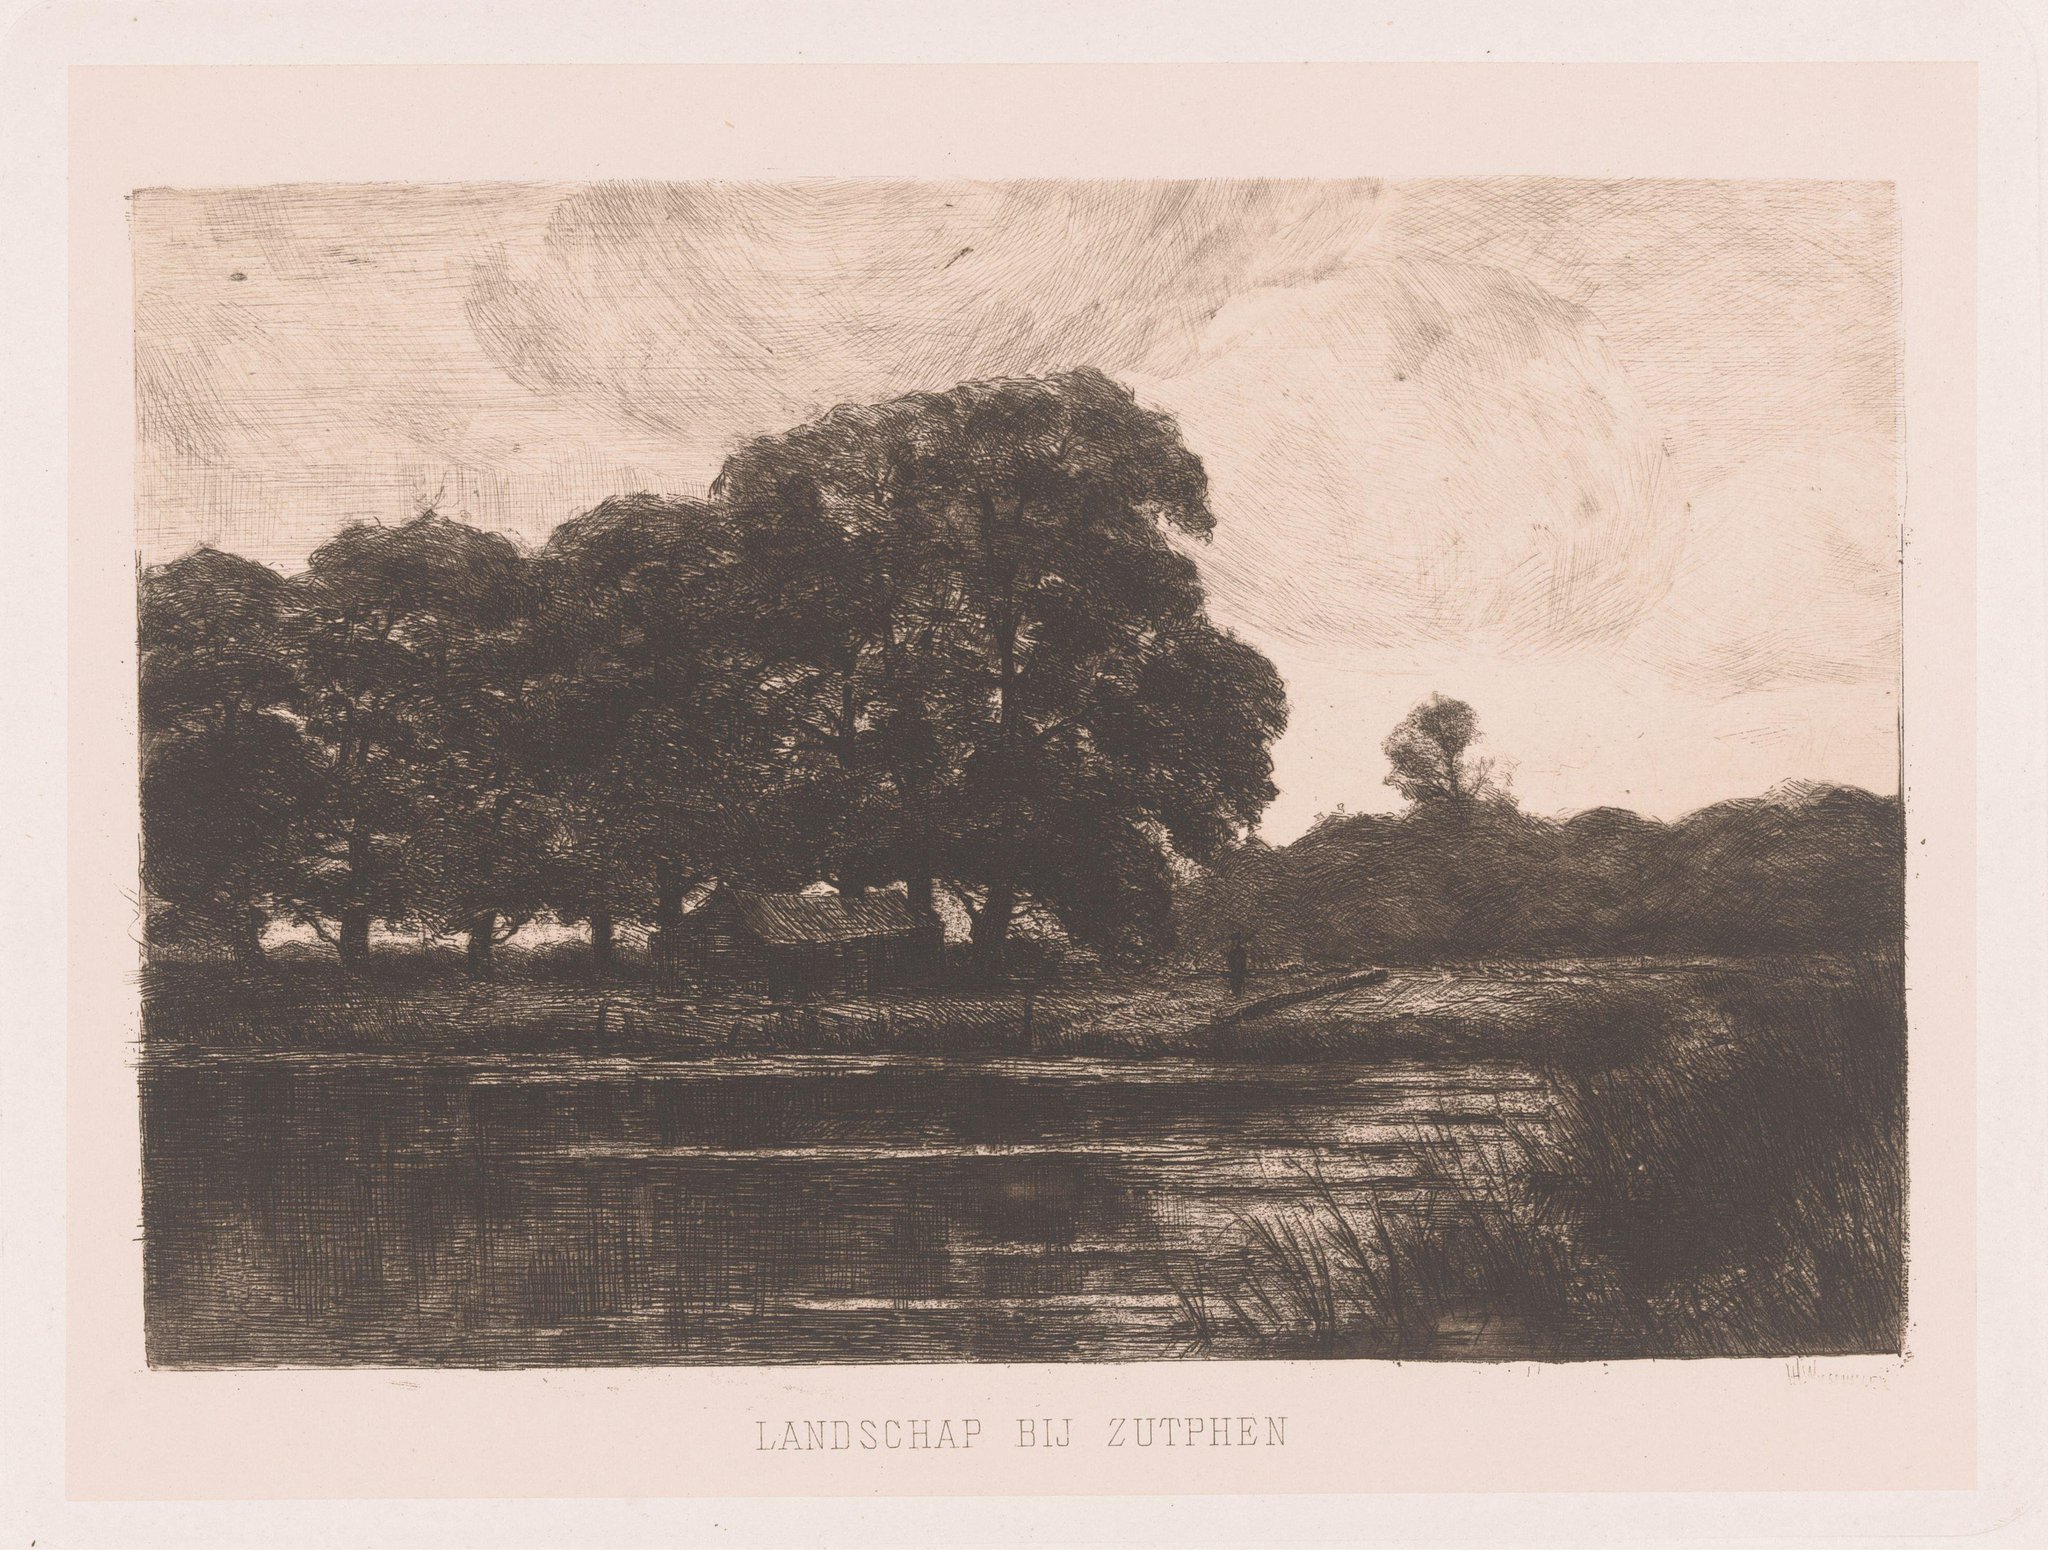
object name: print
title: Landschap bij Zutphen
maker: jan hillebrand wijsmuller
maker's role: painter, print maker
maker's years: 1855-1925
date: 1865-1925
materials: paper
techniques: drypoint, etching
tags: barn, water course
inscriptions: collector's mark: Lugt 2760, collector's mark: Lugt 2228